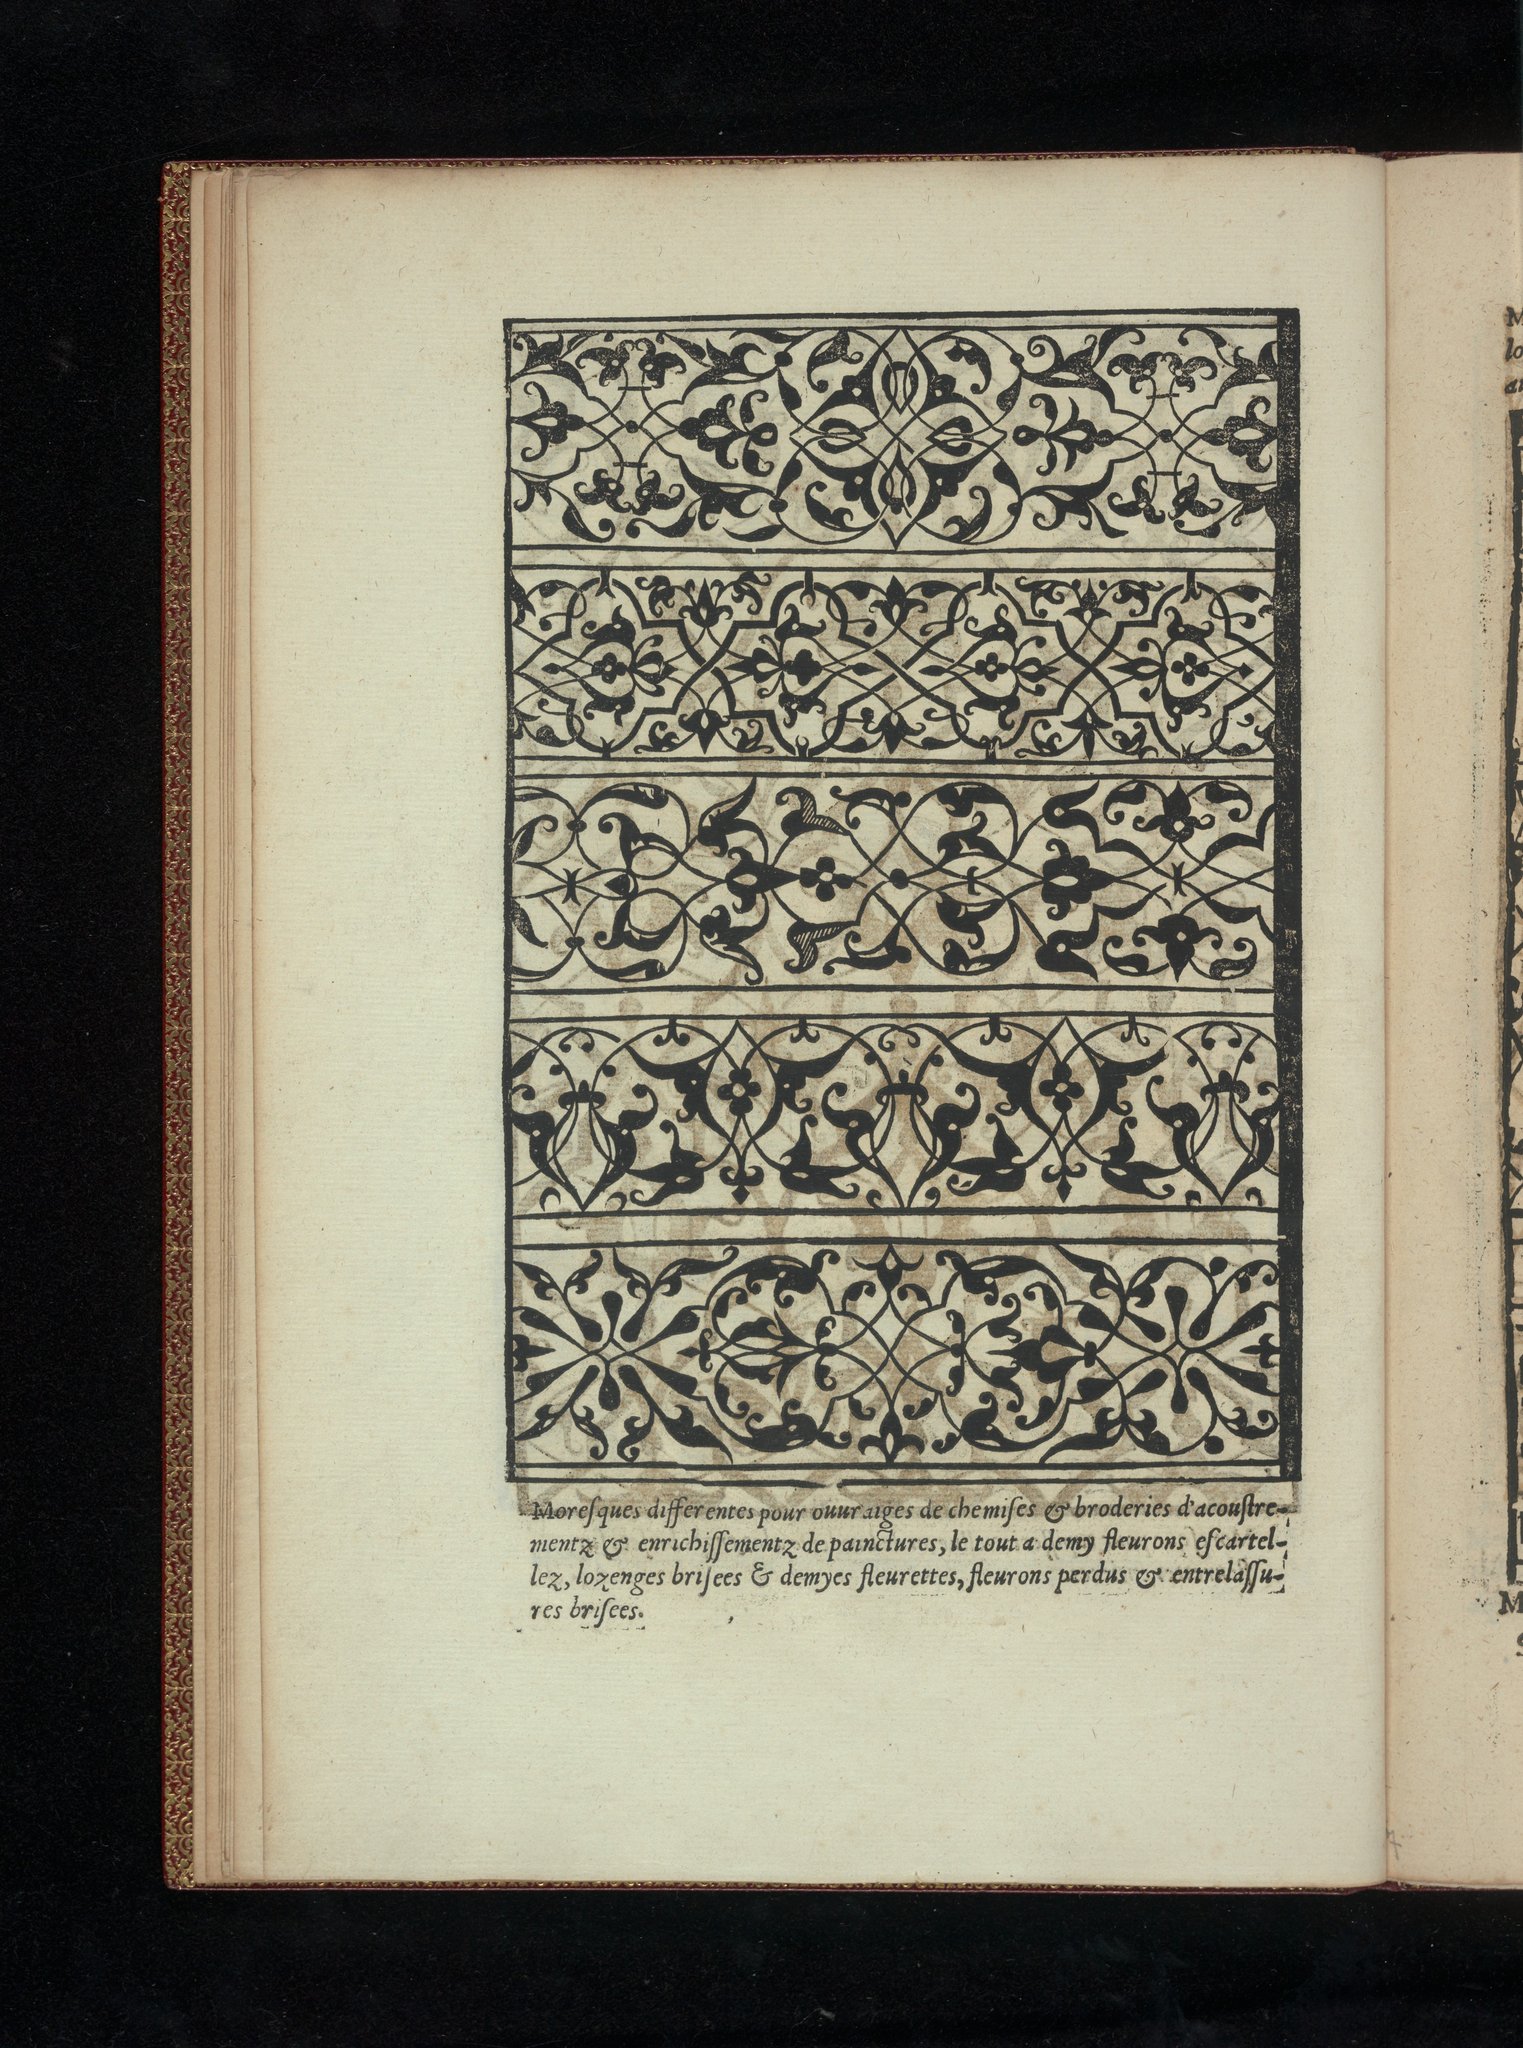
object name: book print ornament architecture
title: Livre de Moresques, page 4 (verso)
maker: francesco di pellegrino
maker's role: artist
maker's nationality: italian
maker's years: 1525-1552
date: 1546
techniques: woodcut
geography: france